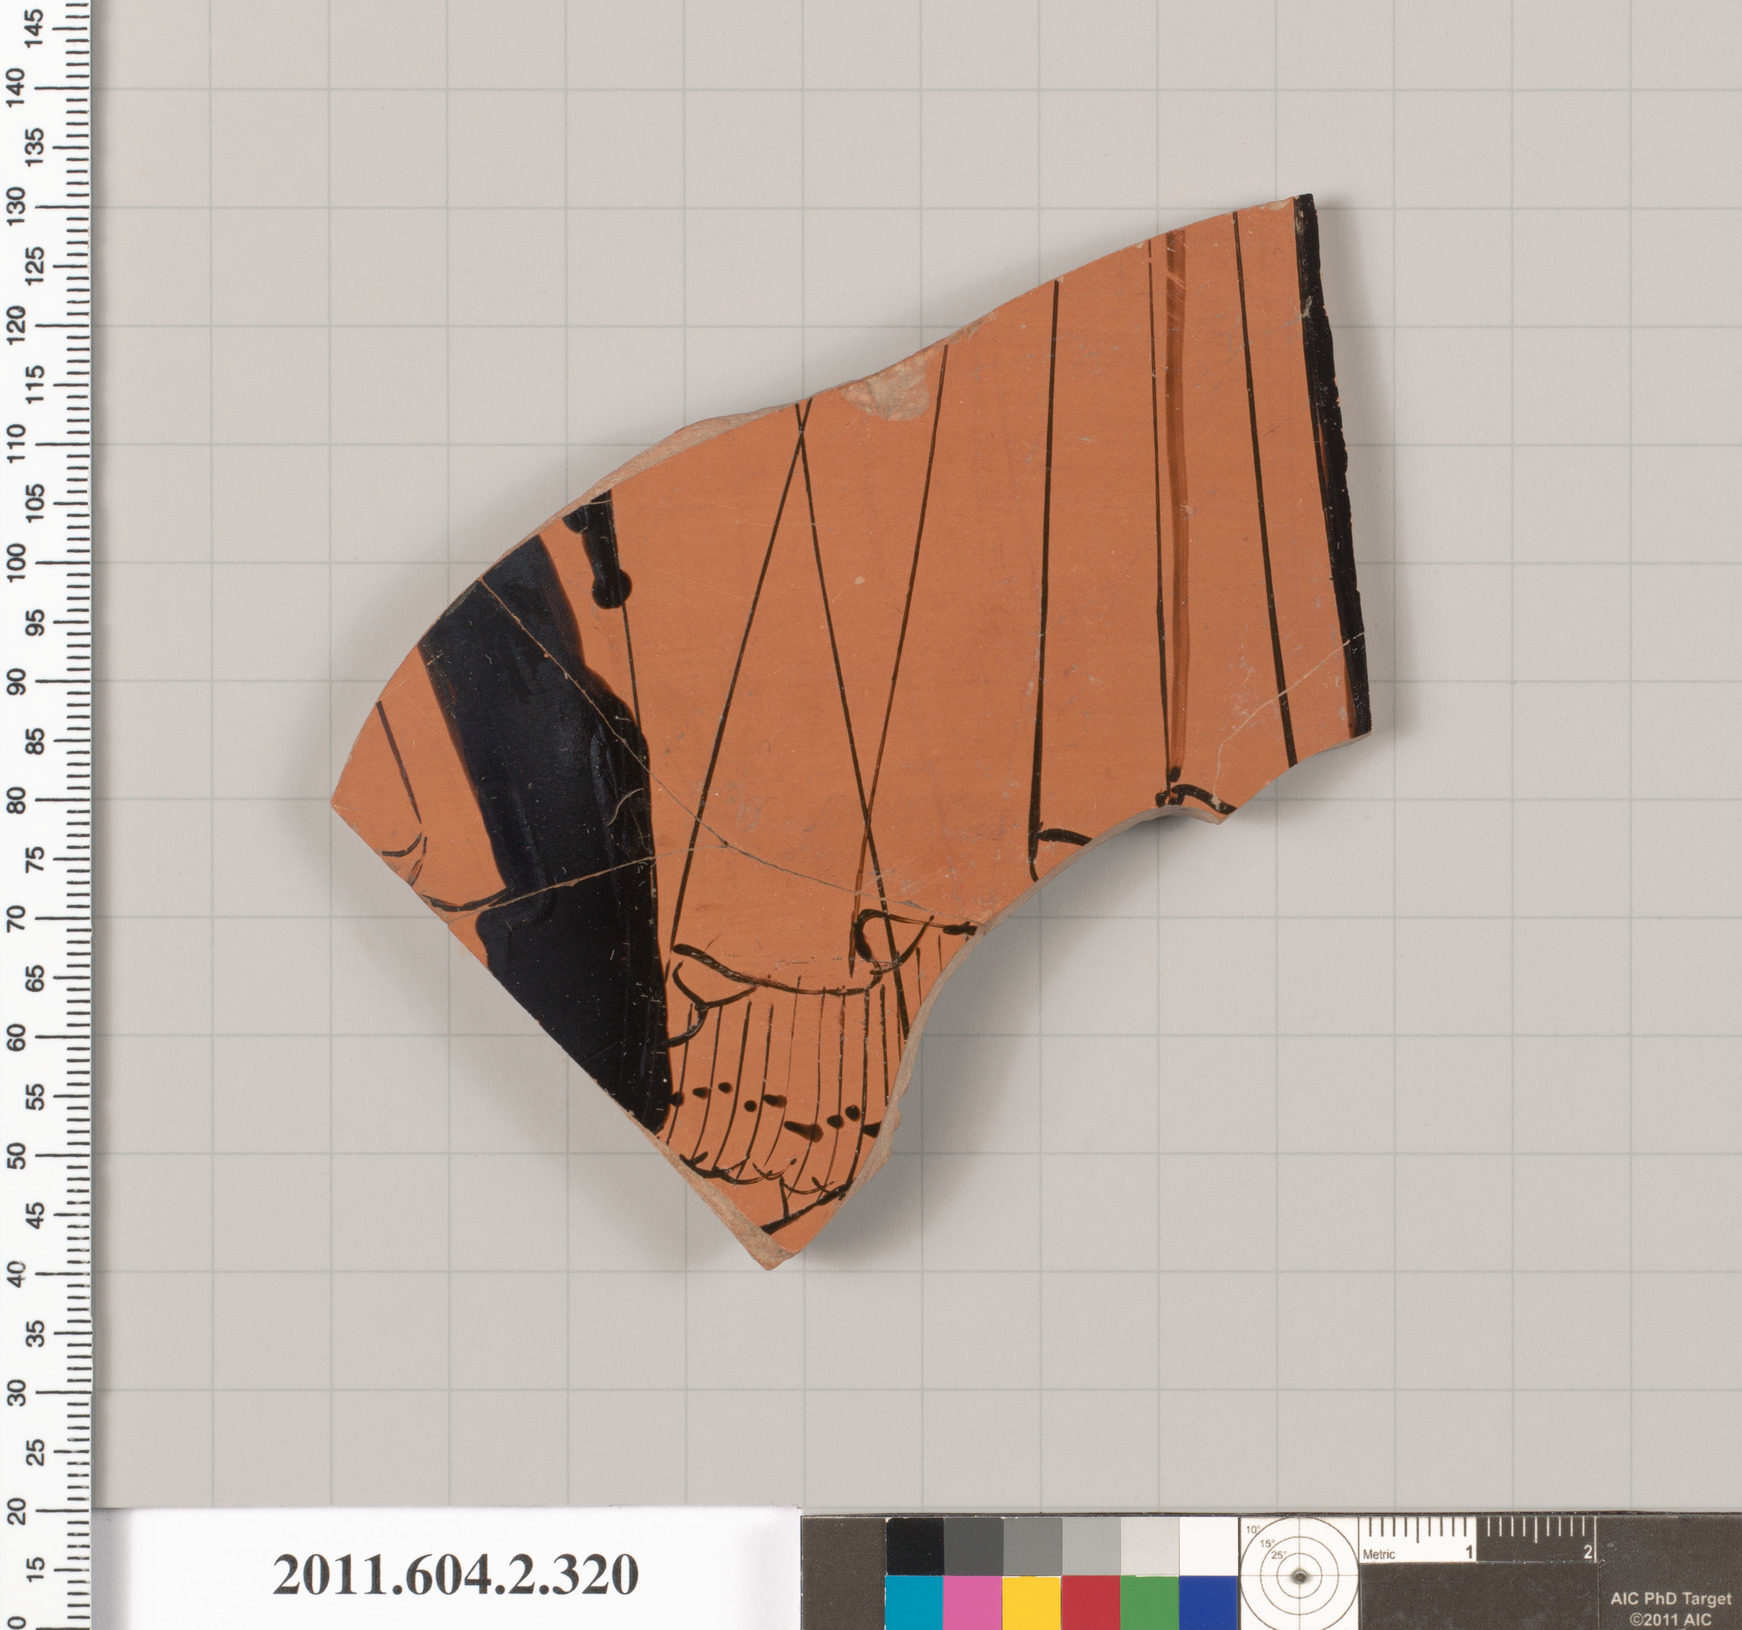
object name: column krater fragment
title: Terracotta fragment of a column-krater (bowl for mixing wine and water)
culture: greek, attic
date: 460-440 BCE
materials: terracotta